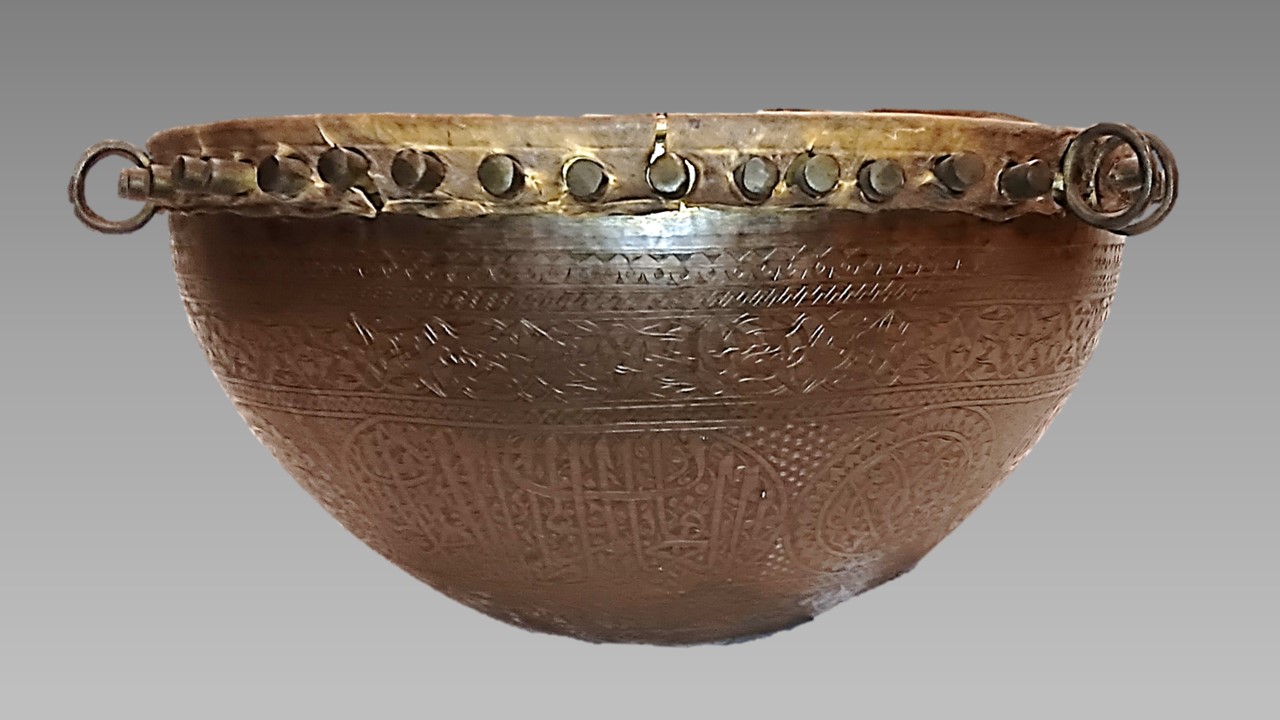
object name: nakakeer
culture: egyptian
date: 1867-1900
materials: copper, skin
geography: egypt